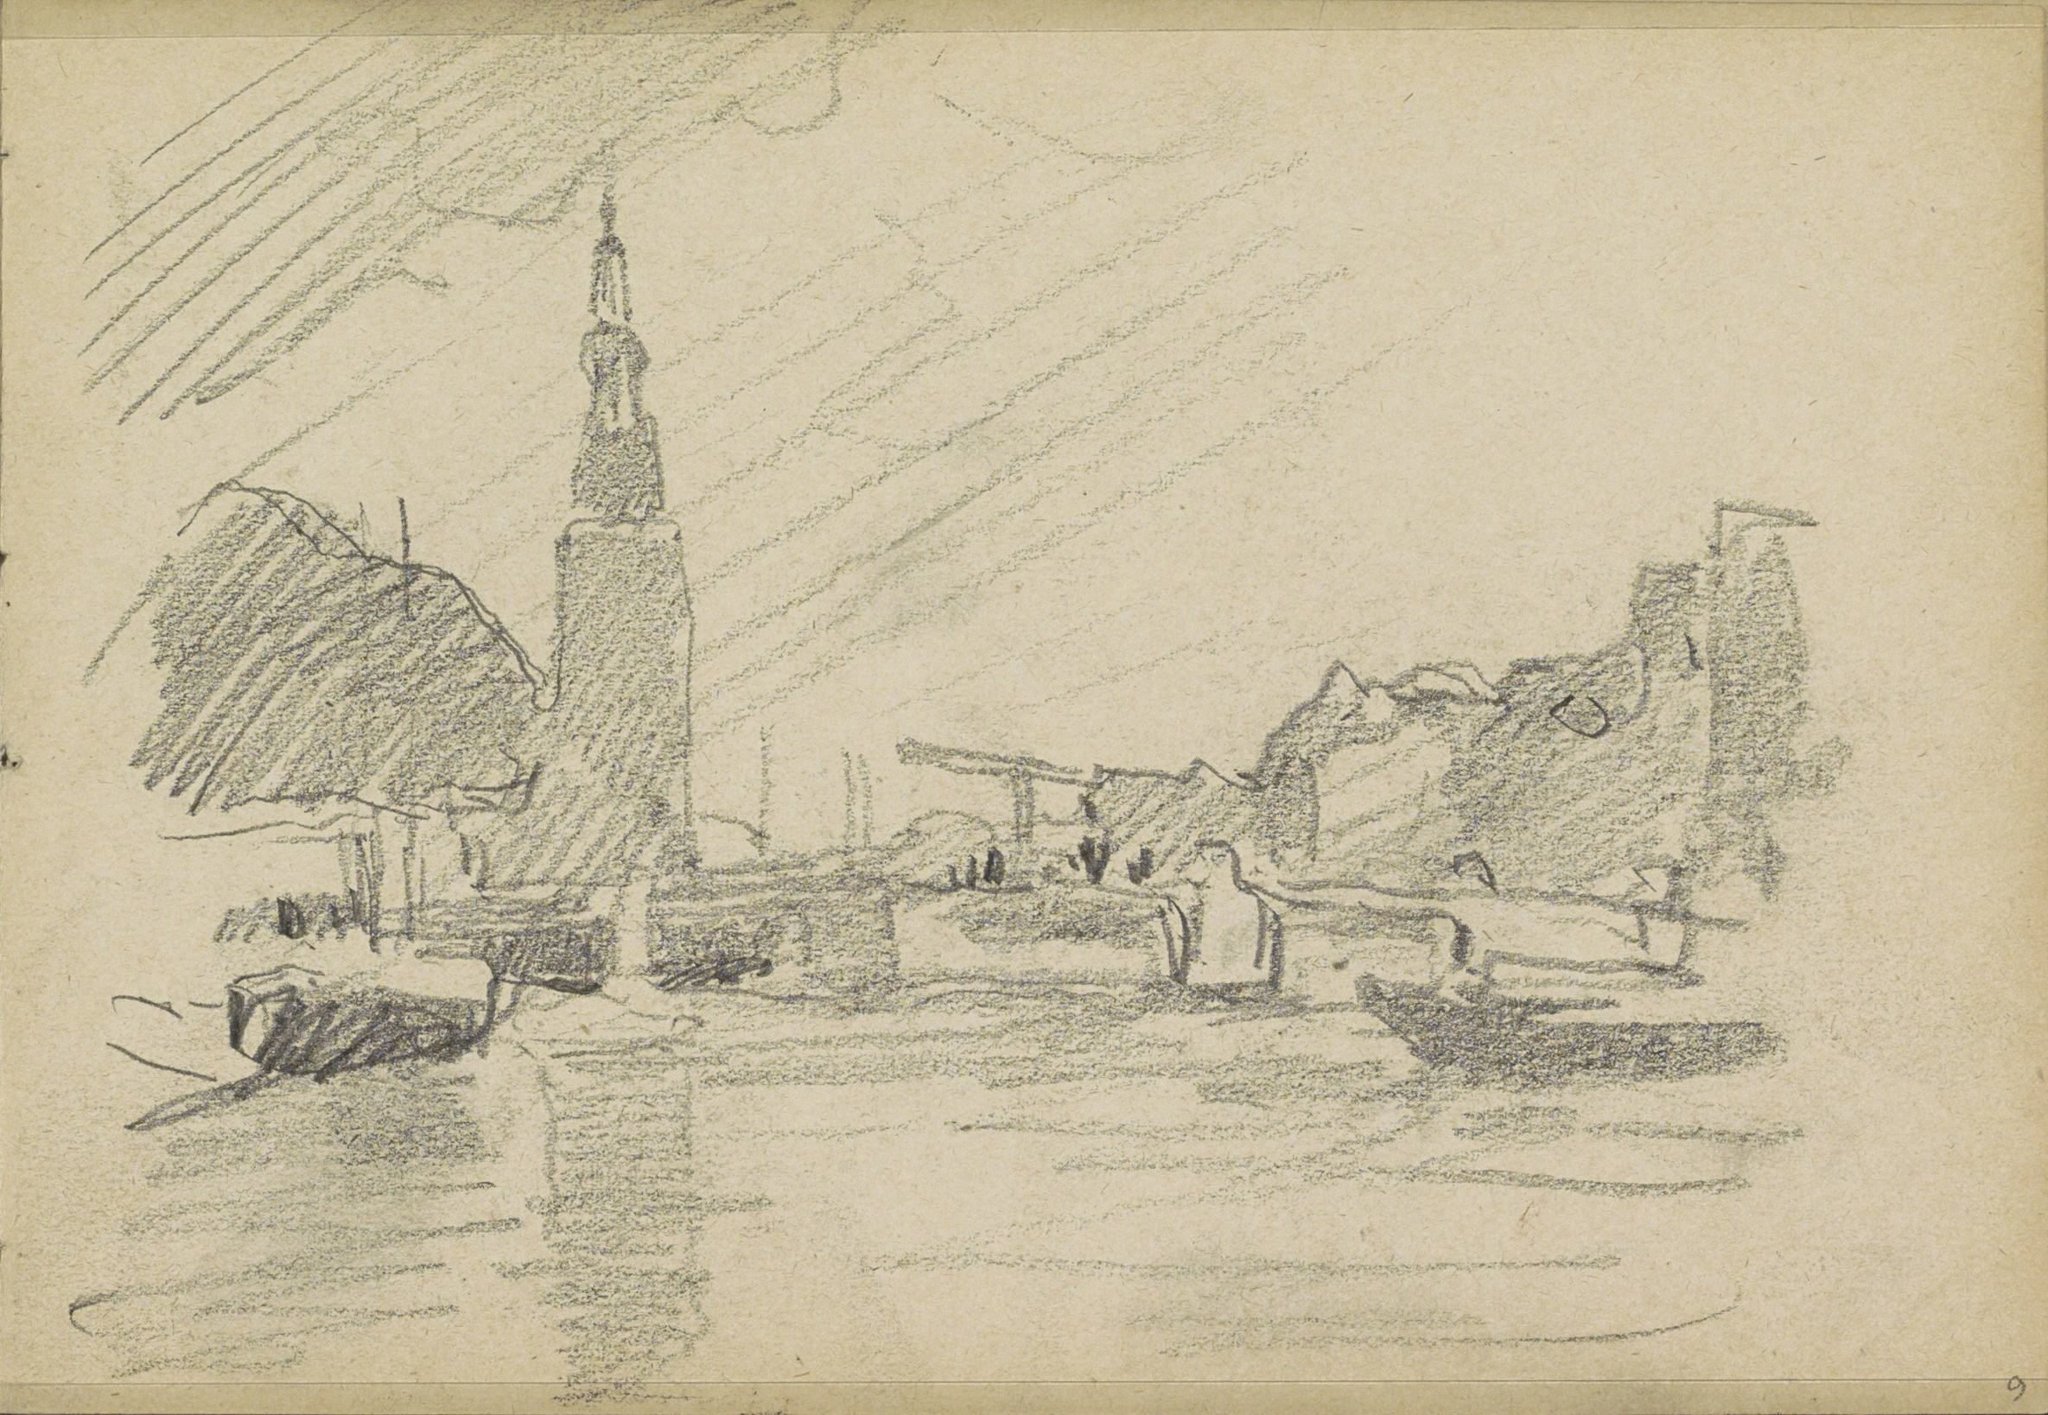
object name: sketchbook leaf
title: Gezicht op de Oudeschans in Amsterdam met de Montelbaanstoren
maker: willem witsen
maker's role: draughtsman, painter, print maker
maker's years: 1860-1923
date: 1887-1920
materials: paper, pencil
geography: amsterdam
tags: bridge in city across river, canal, etc.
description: Pagina 9 uit een schetsboek met 12 bladen.